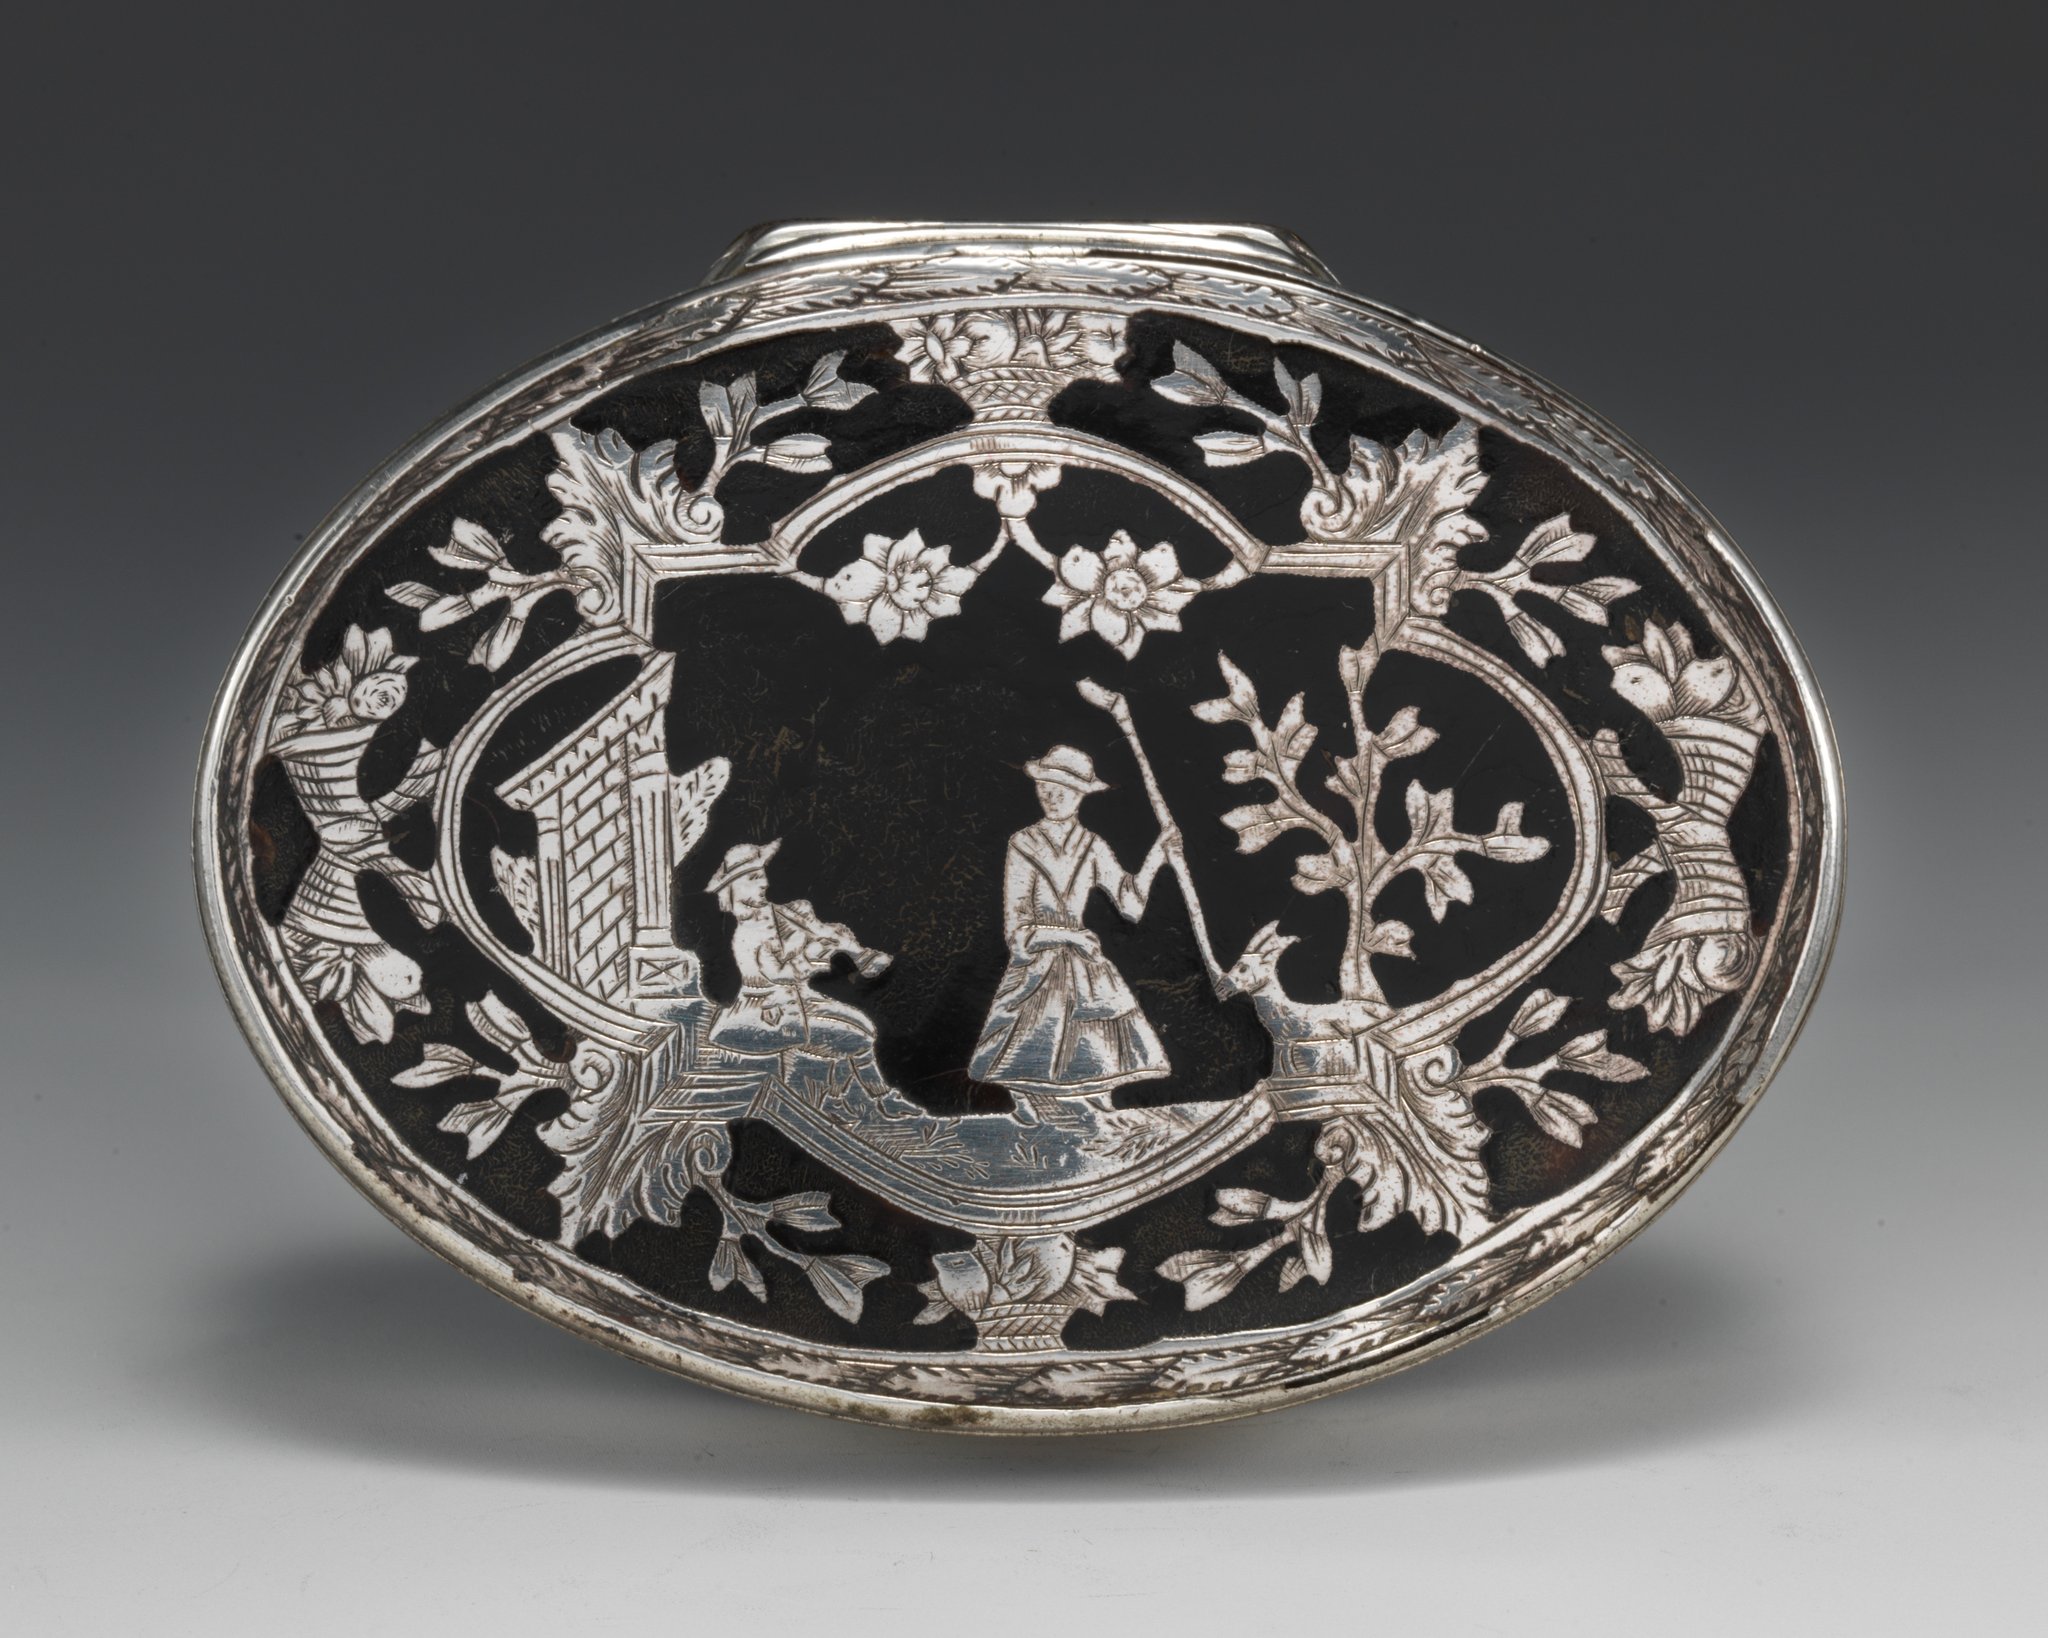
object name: box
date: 1700-1740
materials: silver, shell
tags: human figures,leaves